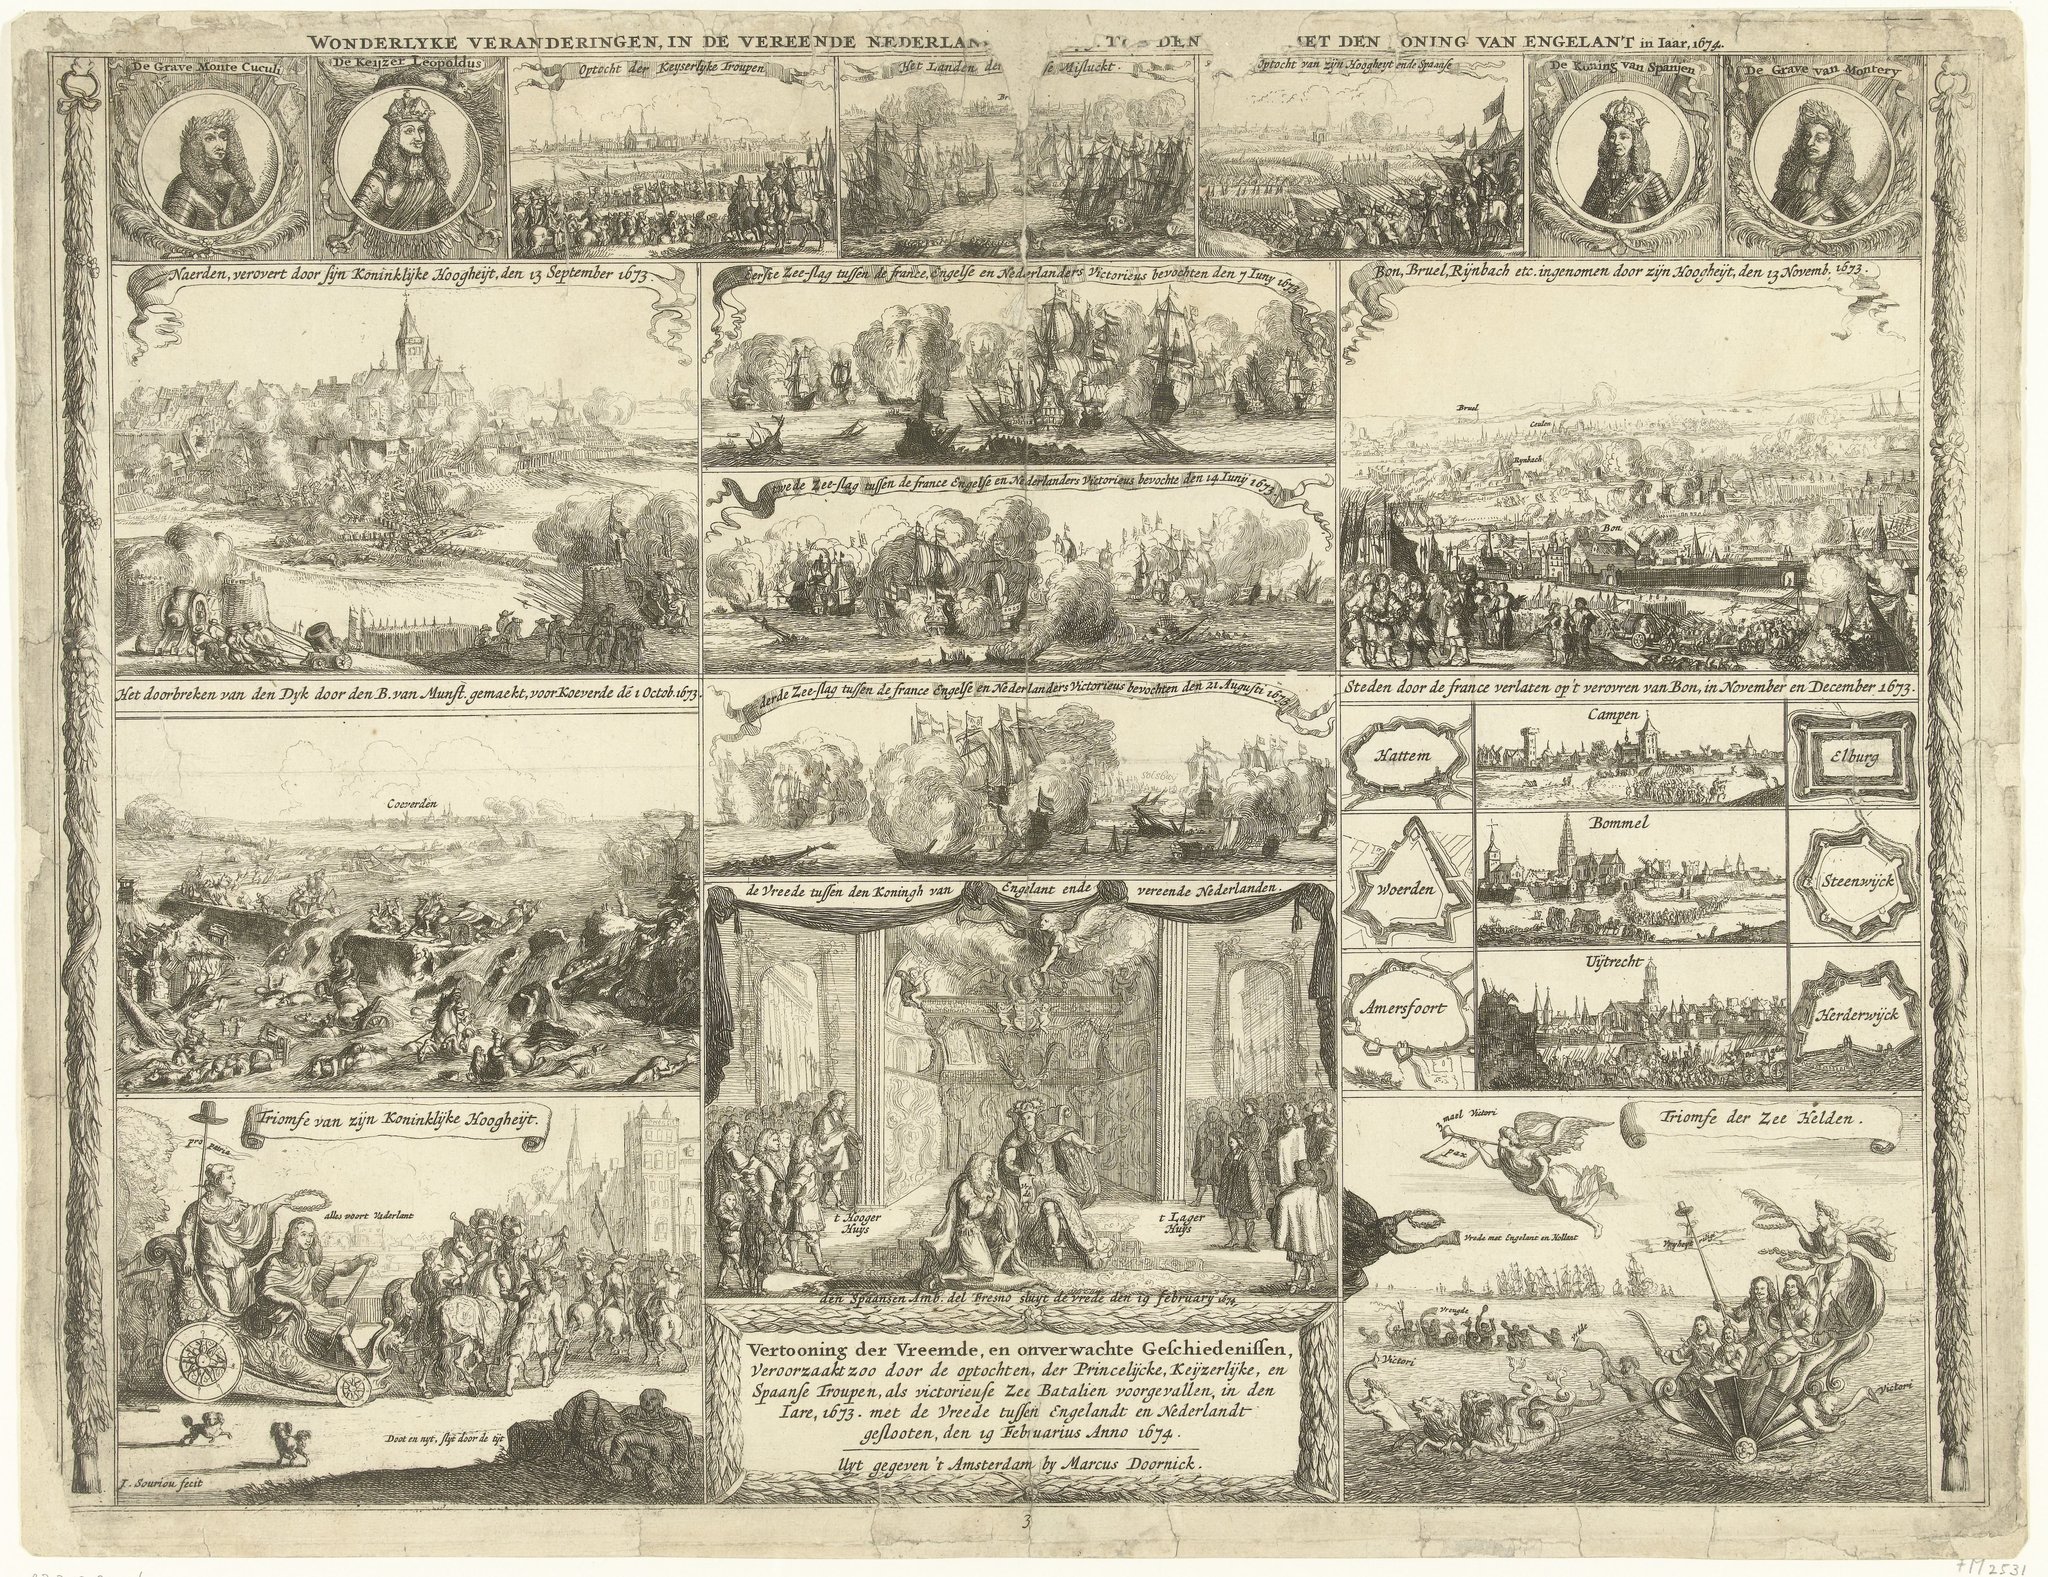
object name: print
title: D' XVII Provincien, met de aengrensende landen en steden als Munster, Ceulen, Bon, Paris, etc. daer beneffens in 2 andere platen vertoont wort, t'geen in derselver Nederlanden Ao. 1672, en 1673, tot 'd Vrede 1674 voorgevallen is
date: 1674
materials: paper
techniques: etching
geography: northern netherlands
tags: flushing, michiel adriaenszoon de ruyter, rotterdam, amsterdam, cornelis tromp, the hague, william iii (prince of orange and king of england, scotland, and ireland), juan domingo méndez de haro y fernández de córdoba, vienna, leopold i (keizer van duitsland), karel ii (koning van spanje), commander-in-chief, admiral (+ naval force), symbolic triumphs of individual persons, signing of peace treaty, concluding the peace, utrecht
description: Blad met een overzicht van de oorlogshandelingen in de jaren 1673 en 1674 leidend tot de Vrede van Westminster met Engeland op 19 februari 1674 waarmee een eind kwam aan de derde Engelse Oorlog. Met vele afzonderlijke voorstellingen van veldslagen, zeeslagen, portretten van de belangrijkste personen, triomfen van prins Willem III en de Nederlandse gezagvoerders ter zee. Centraal onderaan wordt te Westminster de eed op het verdesverdrag afgelegd. Beschadigd exemplaar met onderaan de cijfer 3.